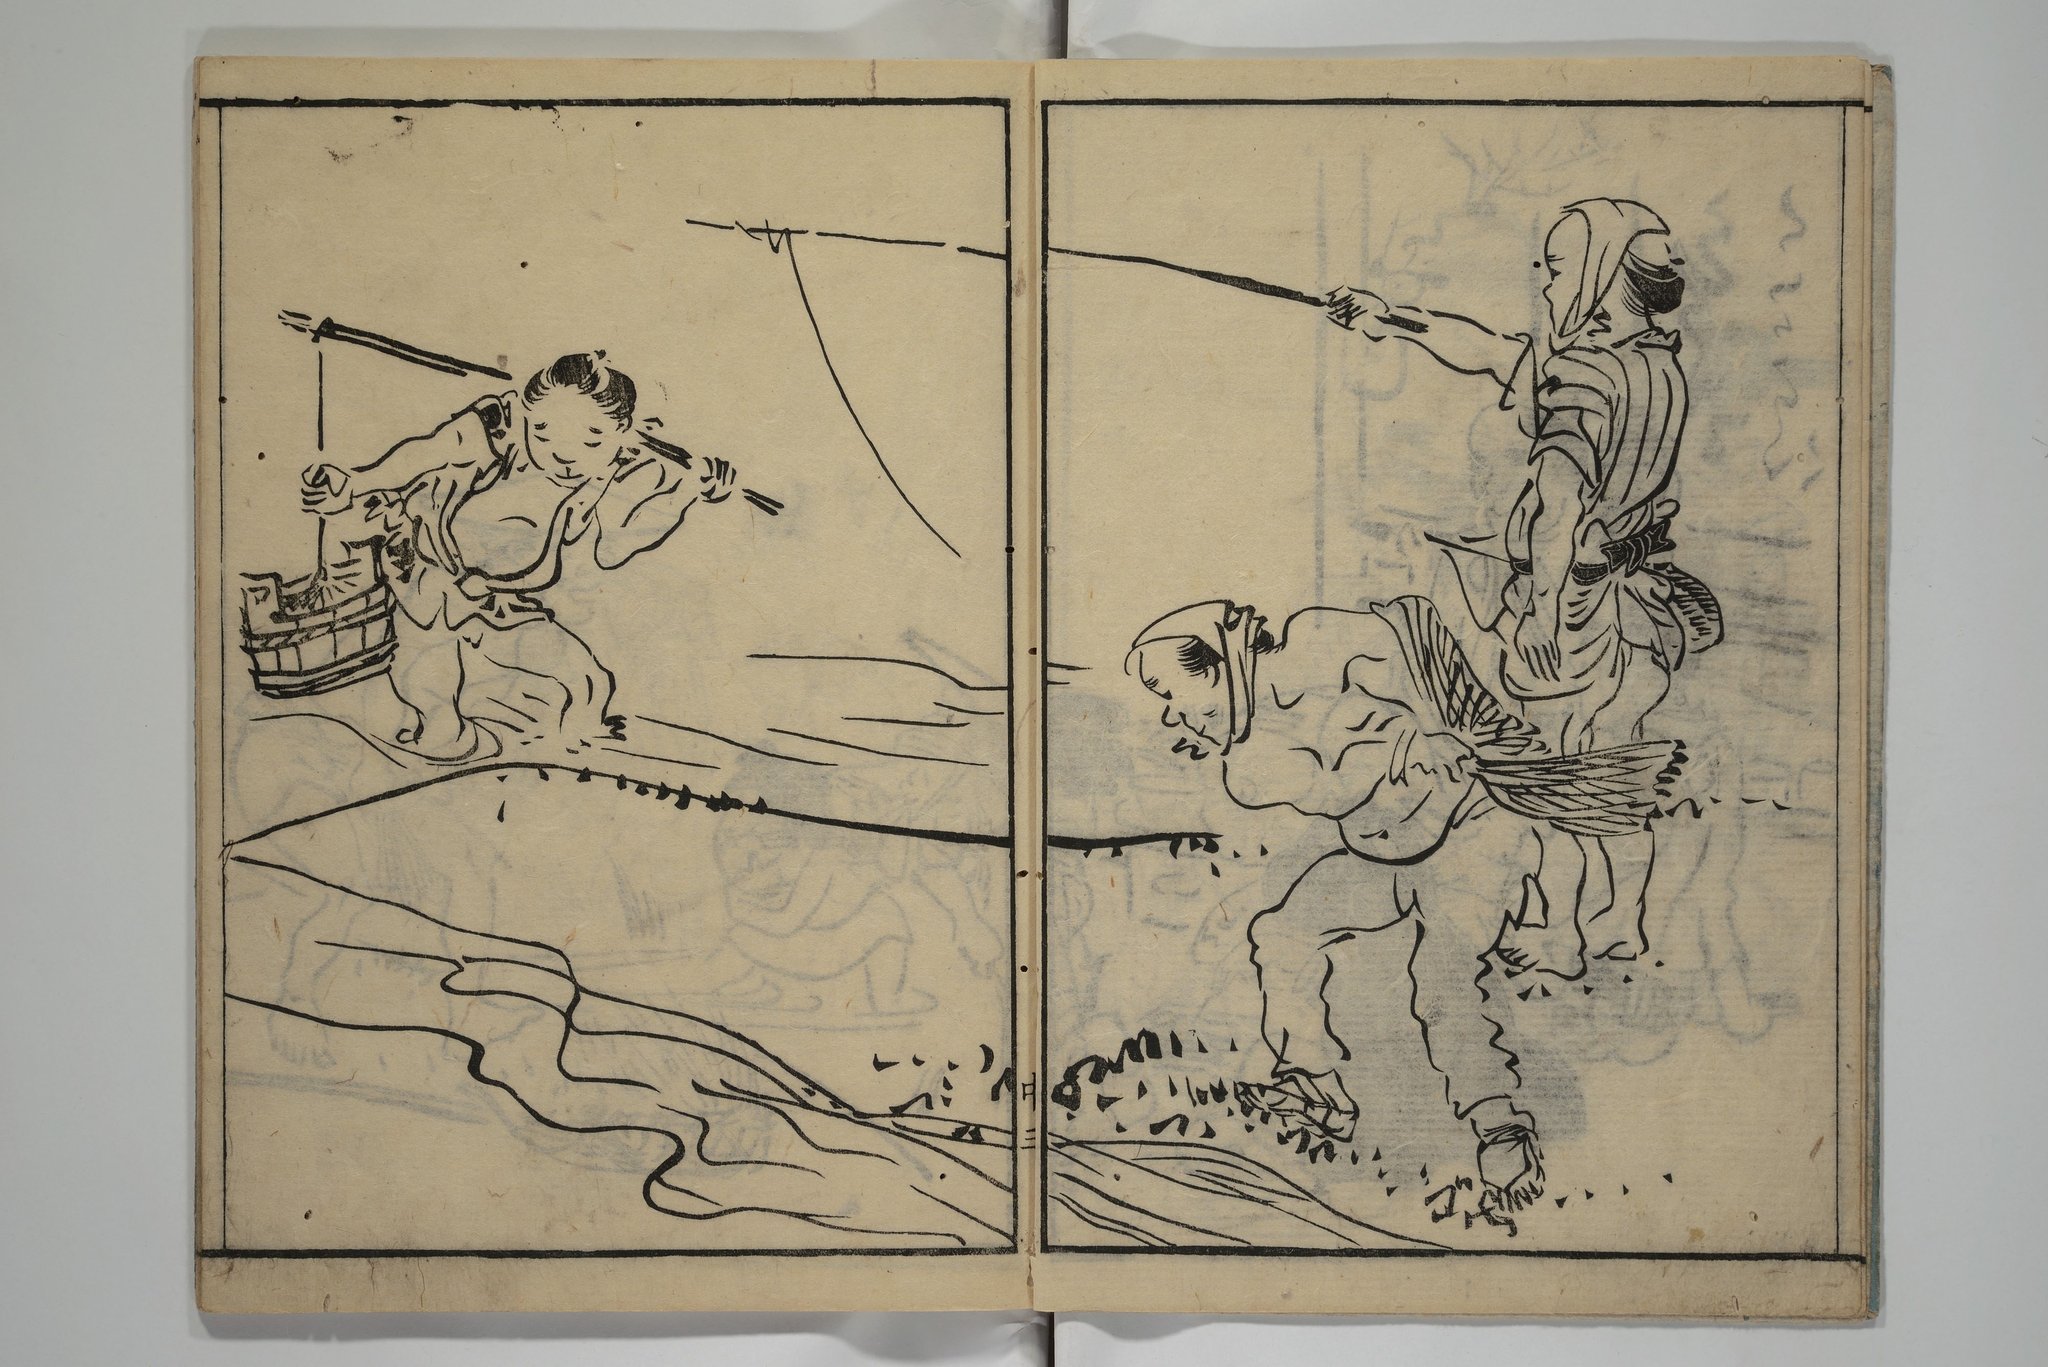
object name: illustrated book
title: The Nantei Picture Album, Supplementary Volume (Nantei gafu kōhen) 楠亭画譜後篇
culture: japanese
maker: nishimura nantei 西村 楠亭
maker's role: artist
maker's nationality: japanese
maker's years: 1775-1834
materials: ink, paper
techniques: woodblock print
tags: men,fishing